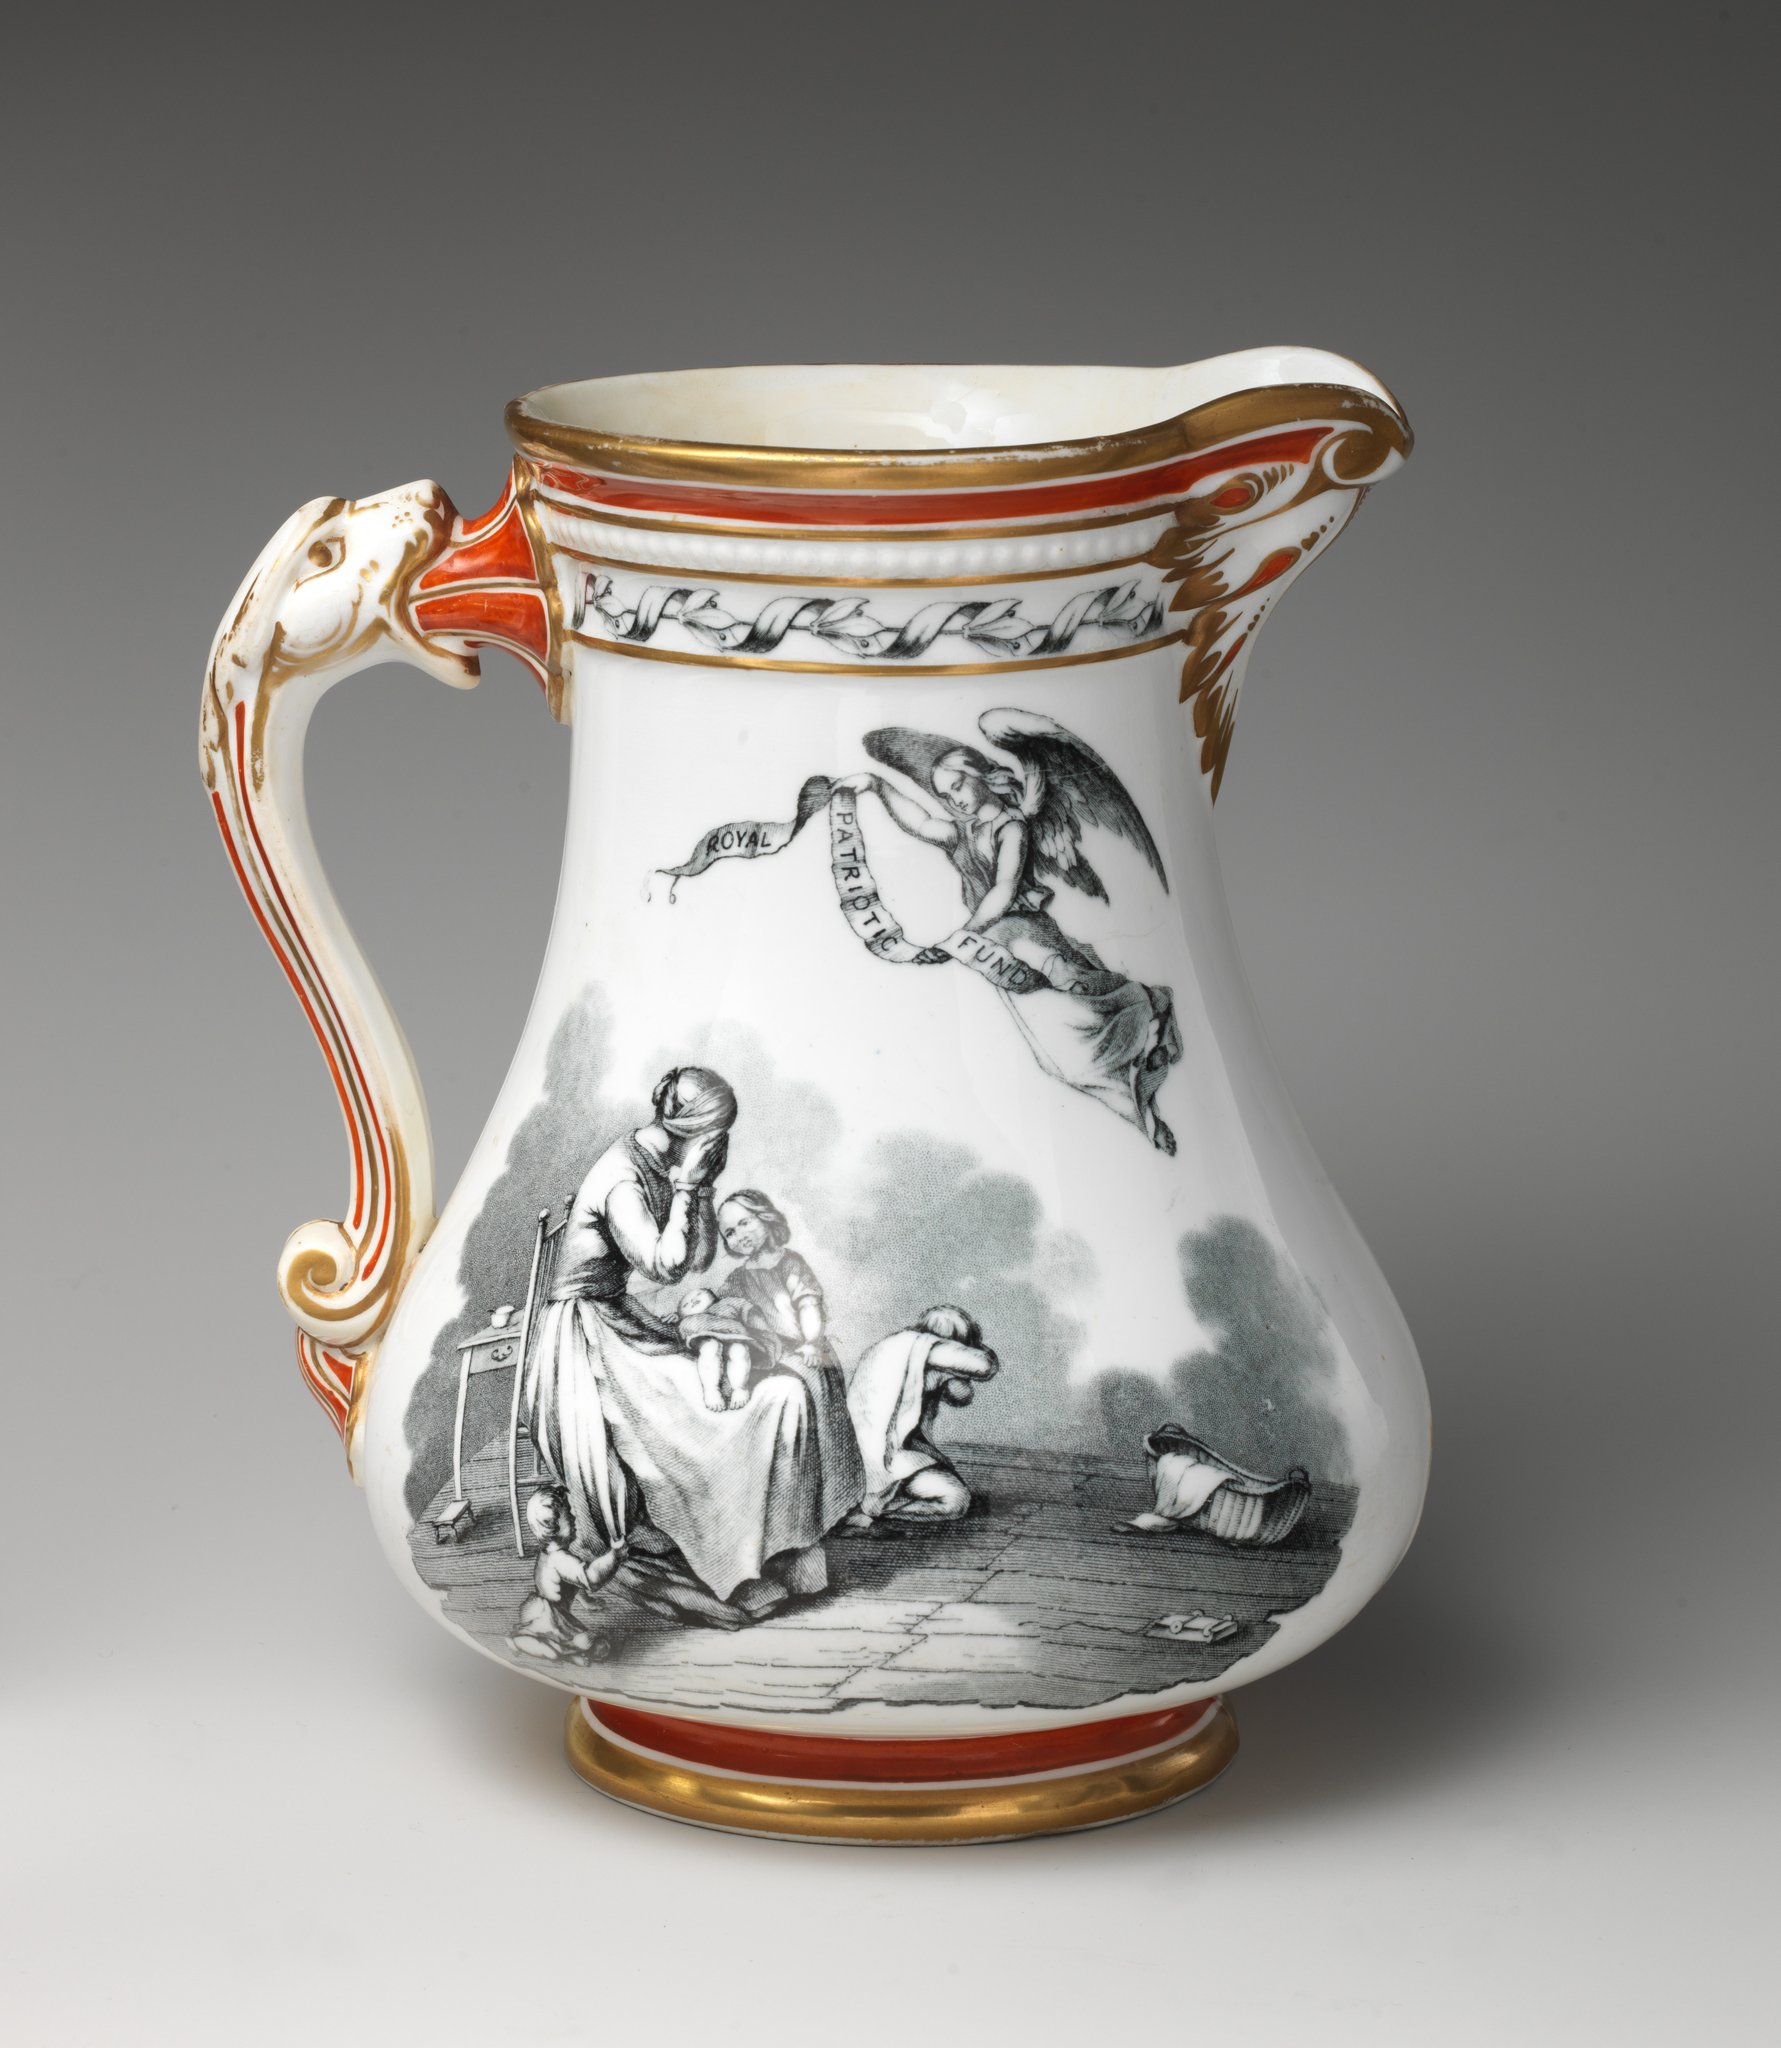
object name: jug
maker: george edward eyre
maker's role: designer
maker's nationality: british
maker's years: 1818-1887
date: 1855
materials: porcelain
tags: soldiers,sadness,children,women